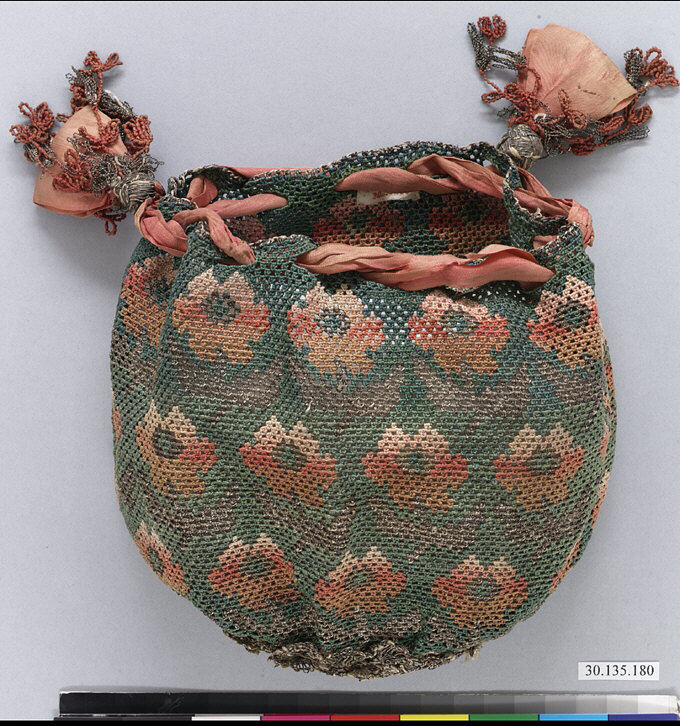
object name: bag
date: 1601-1700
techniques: crochet